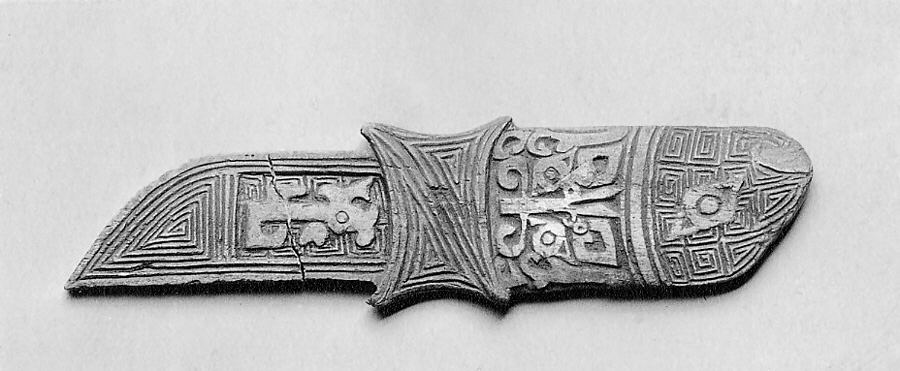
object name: dagger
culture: chinese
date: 1047-771 BCE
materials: ivory